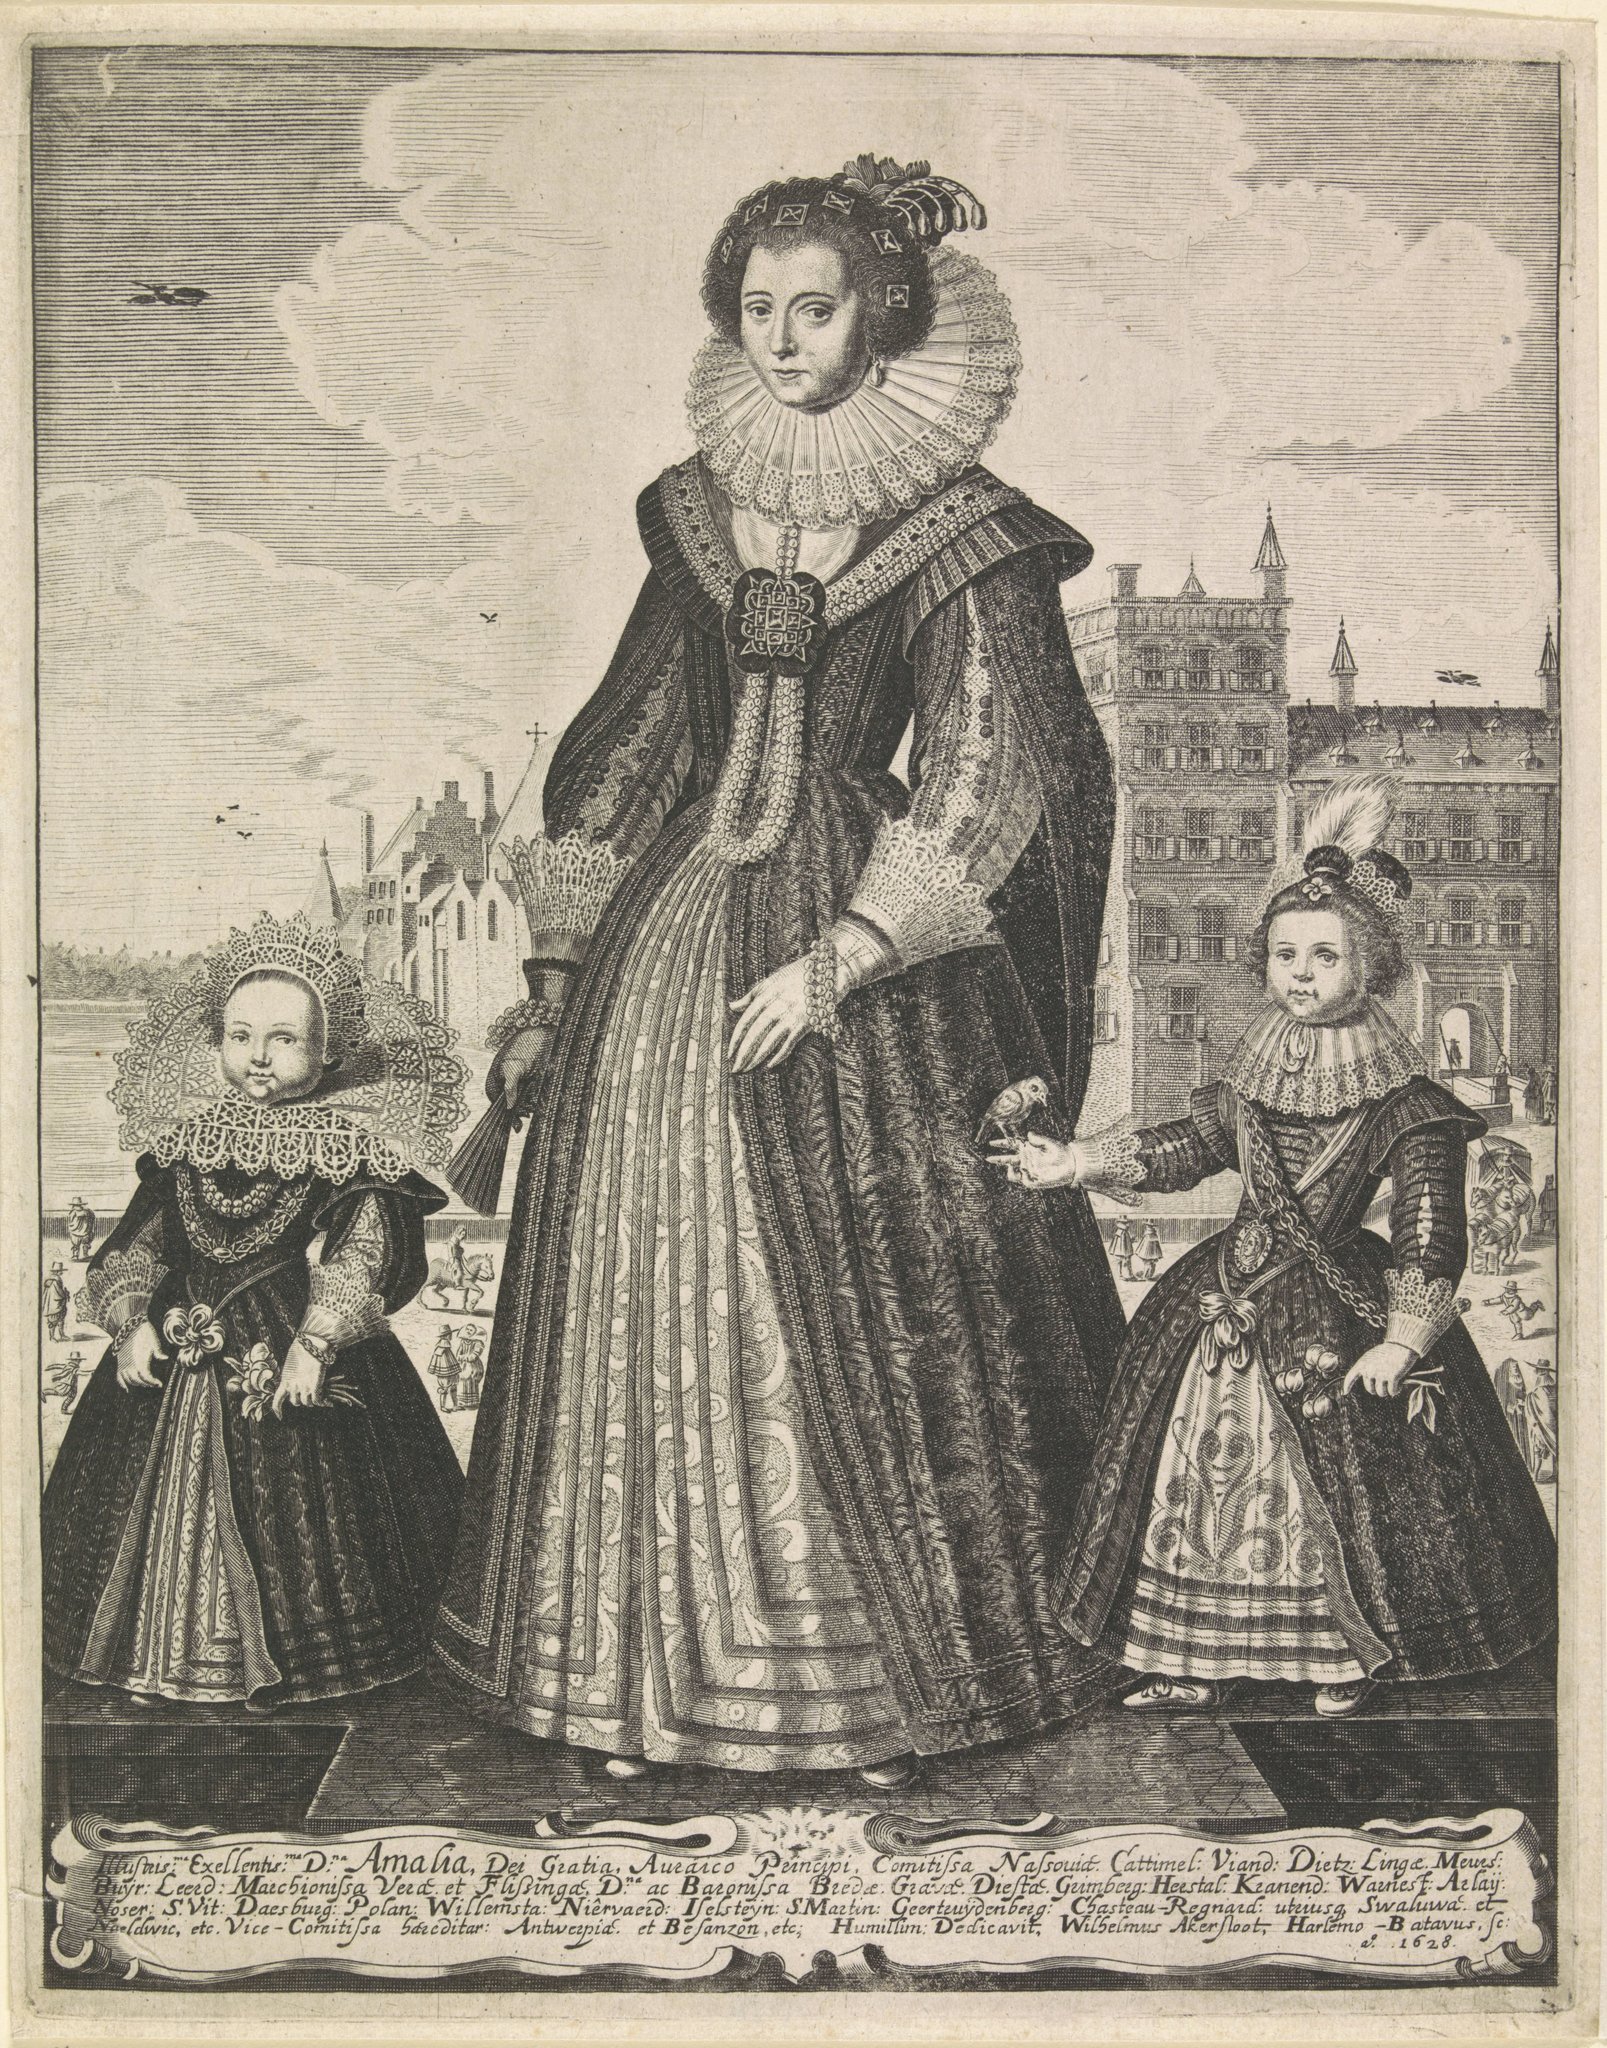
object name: print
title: Portret van Amalia van Solms, Willem II, prins van Oranje, en Louise Henriëtte, prinses van Oranje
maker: willem outgertsz. akersloot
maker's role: print maker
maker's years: 1600-1651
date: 1628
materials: paper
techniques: engraving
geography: northern netherlands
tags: william ii (prince of orange), amalia of solms-braunfels, berlin, louise henriëtte (prinses van oranje), brooch, agraffe, clasp (+ women's clothes), clothes, costume (+ children's clothes), dress, gown (vlieger) (+ women's clothes), sleeves: cuffs (+ women's clothes), neck-gear ~ clothing (with name) (+ fur used for clothes), sleeves (+ women's clothes)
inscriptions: date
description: Portret van Amalia ten voeten uit, staande voor het Binnenhof in Den Haag, met haar kinderen prins Willem en prinses Louise-Henriette. Prins Willem heeft een bloem in zijn linker en een vogeltje op zijn rechterhand.